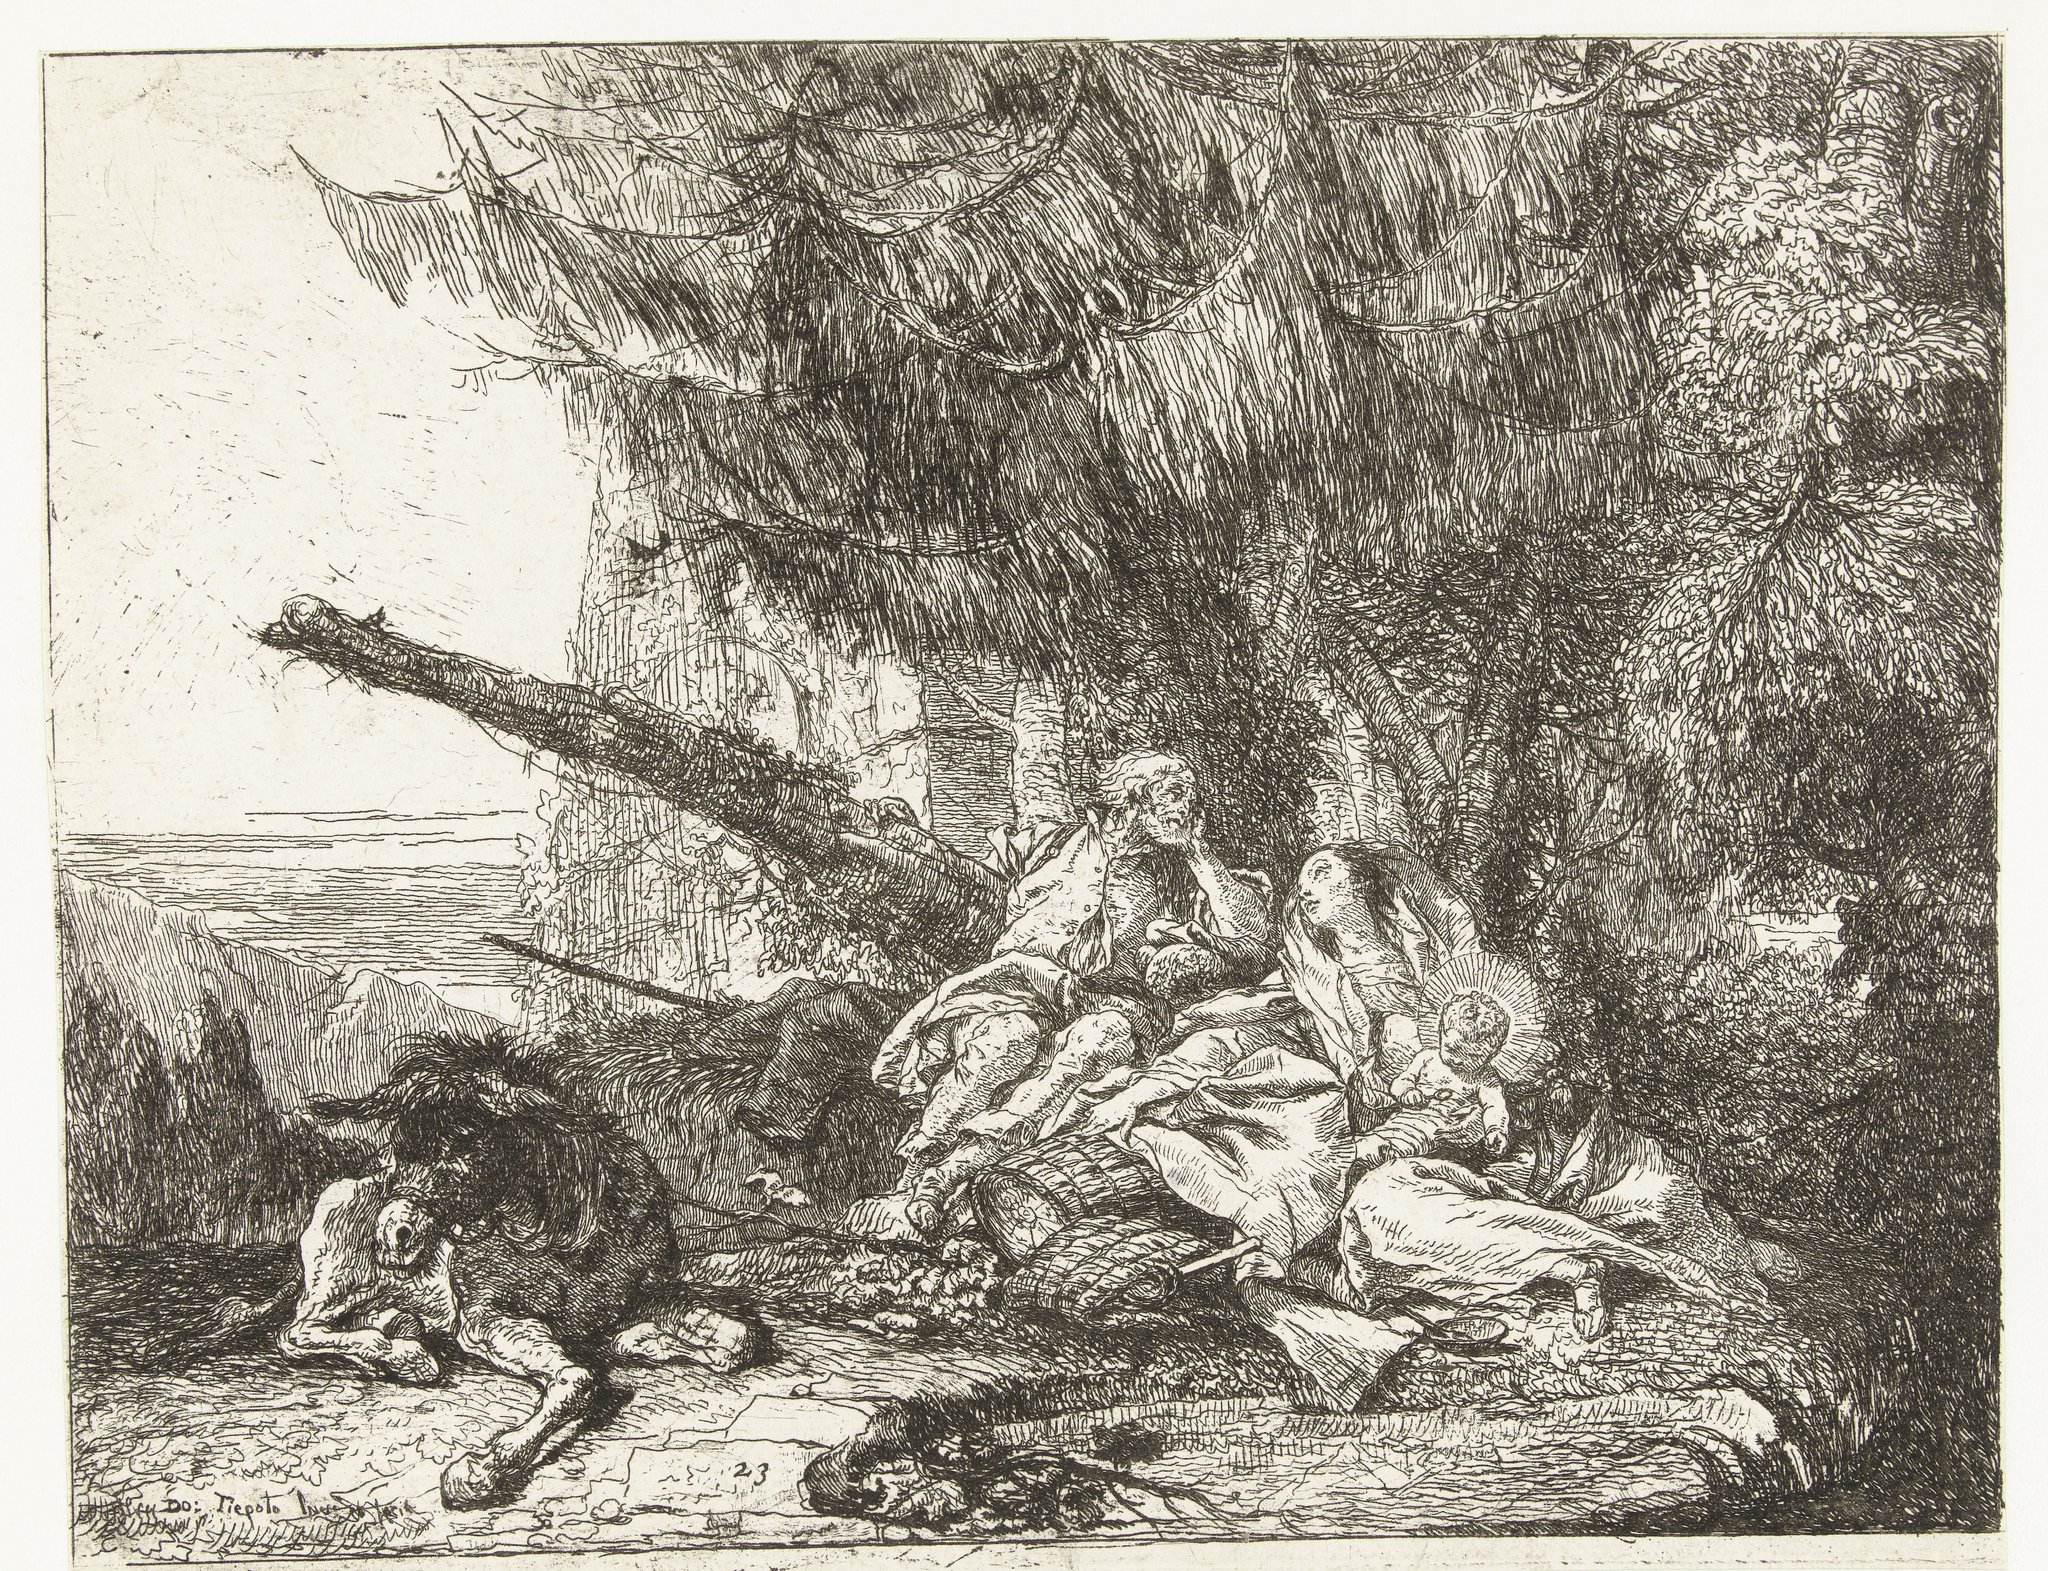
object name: print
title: Vlucht naar Egypte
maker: giovanni domenico tiepolo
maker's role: draughtsman, print maker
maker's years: 1727-1804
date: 1750-1753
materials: paper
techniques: etching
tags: flight into egypt and miracles during the journey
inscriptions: collector's mark: Lugt 2760, collector's mark: Lugt 2228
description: Prent uit serie van zevenentwintig prenten met de Vlucht naar Egypte.